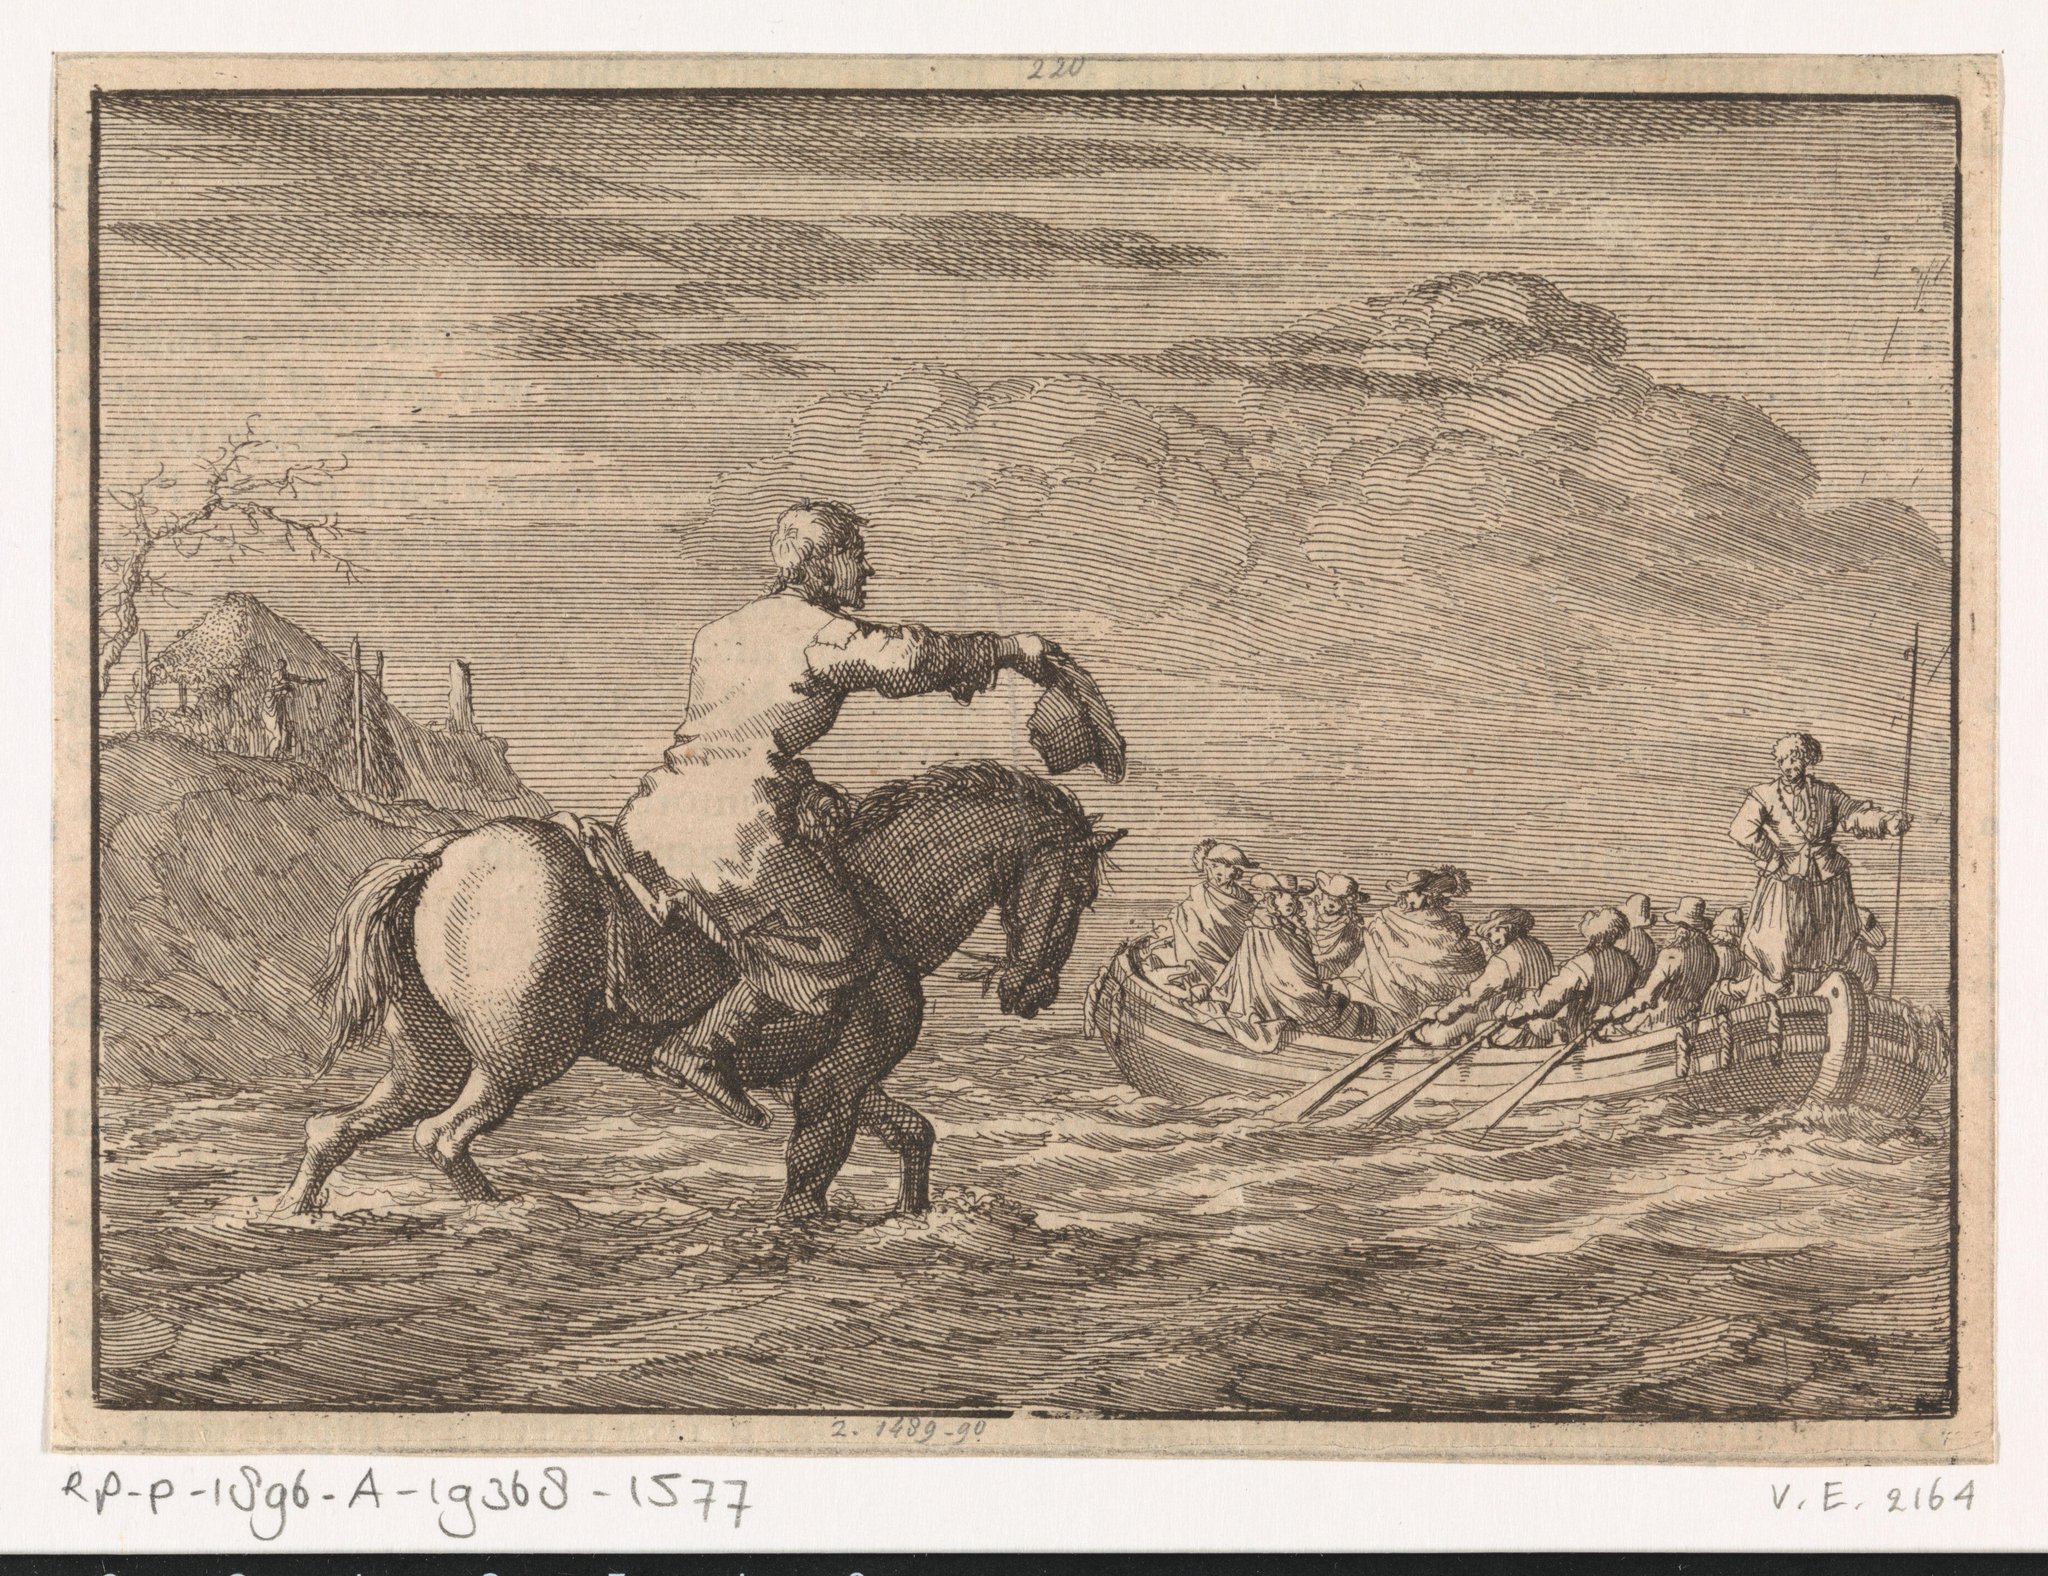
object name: book illustration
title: Aankomst van Willem III bij de Oranjepolder in een roeischuit, 1691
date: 1698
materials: paper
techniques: etching, letterpress printing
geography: amsterdam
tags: the hague, william iii (prince of orange and king of england, scotland, and ireland), being welcomed ~ travelling, rowing-boat, canoe, etc.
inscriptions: collector's mark: Lugt 2228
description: Illustratie uit: Gottfried, Johann Ludwig. Historische kronyck; vervattende een (...) beschrijvingh der aldergedenckwaerdigste geschiedenissen des weerelds, van den aenvangh der scheppingh tot (...) 1576 (2 delen). Leiden: Pieter van der Aa, 1698, dl. II, p. 1489.